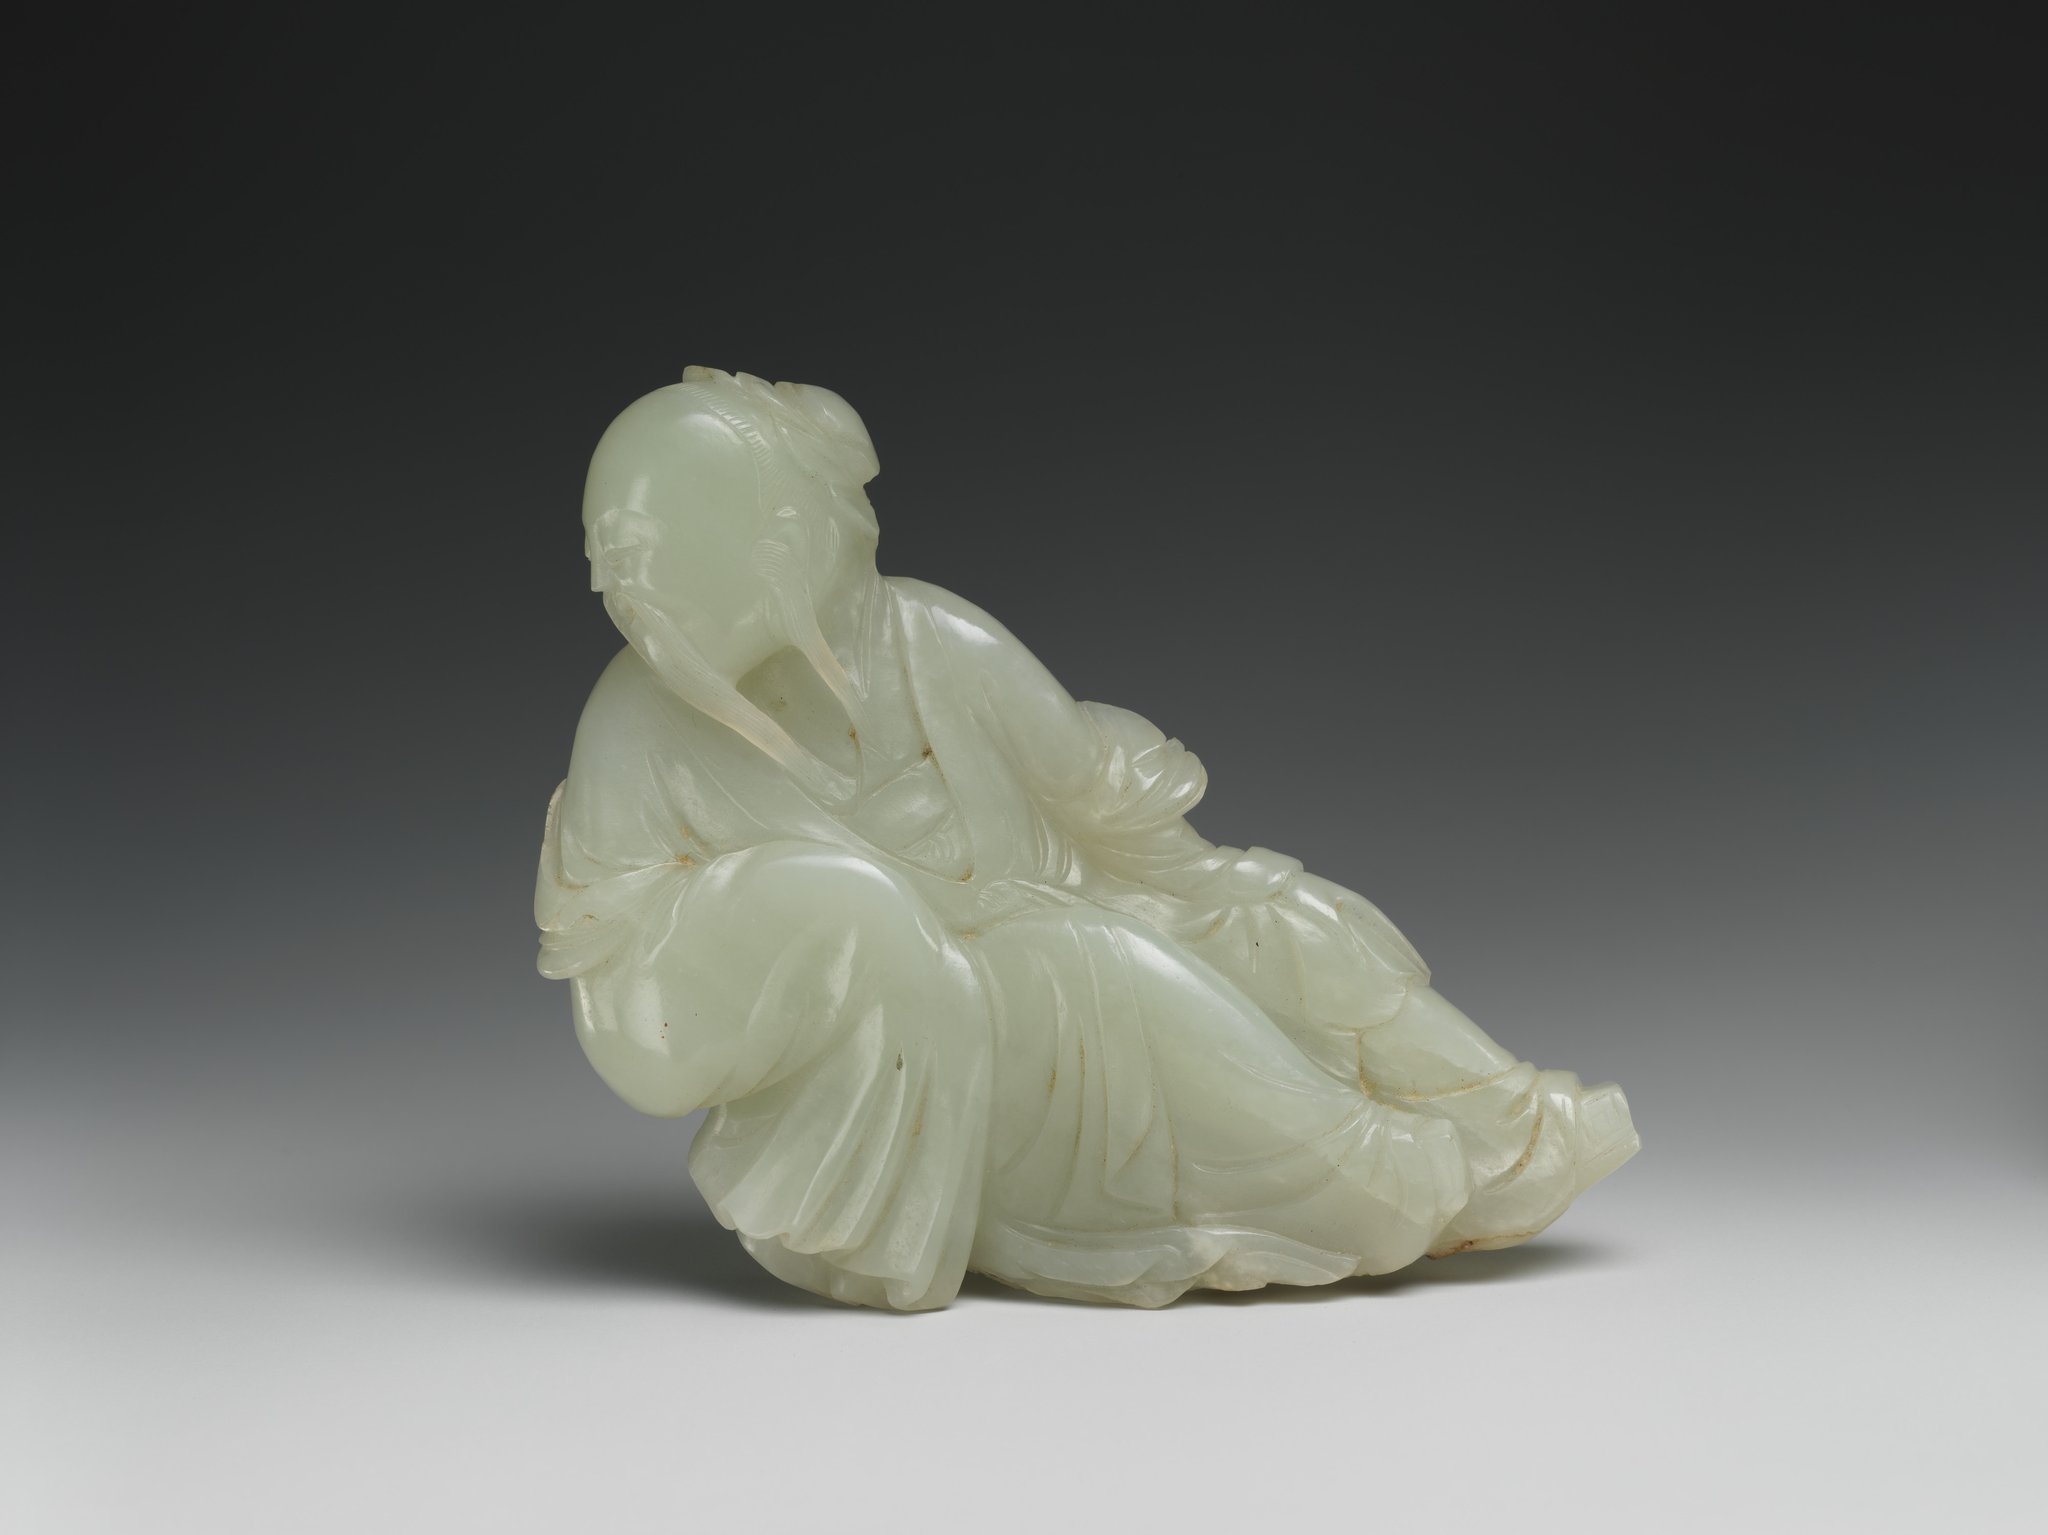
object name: figure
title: Figure of a scholar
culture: chinese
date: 1701-1800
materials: jade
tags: men,philosophers